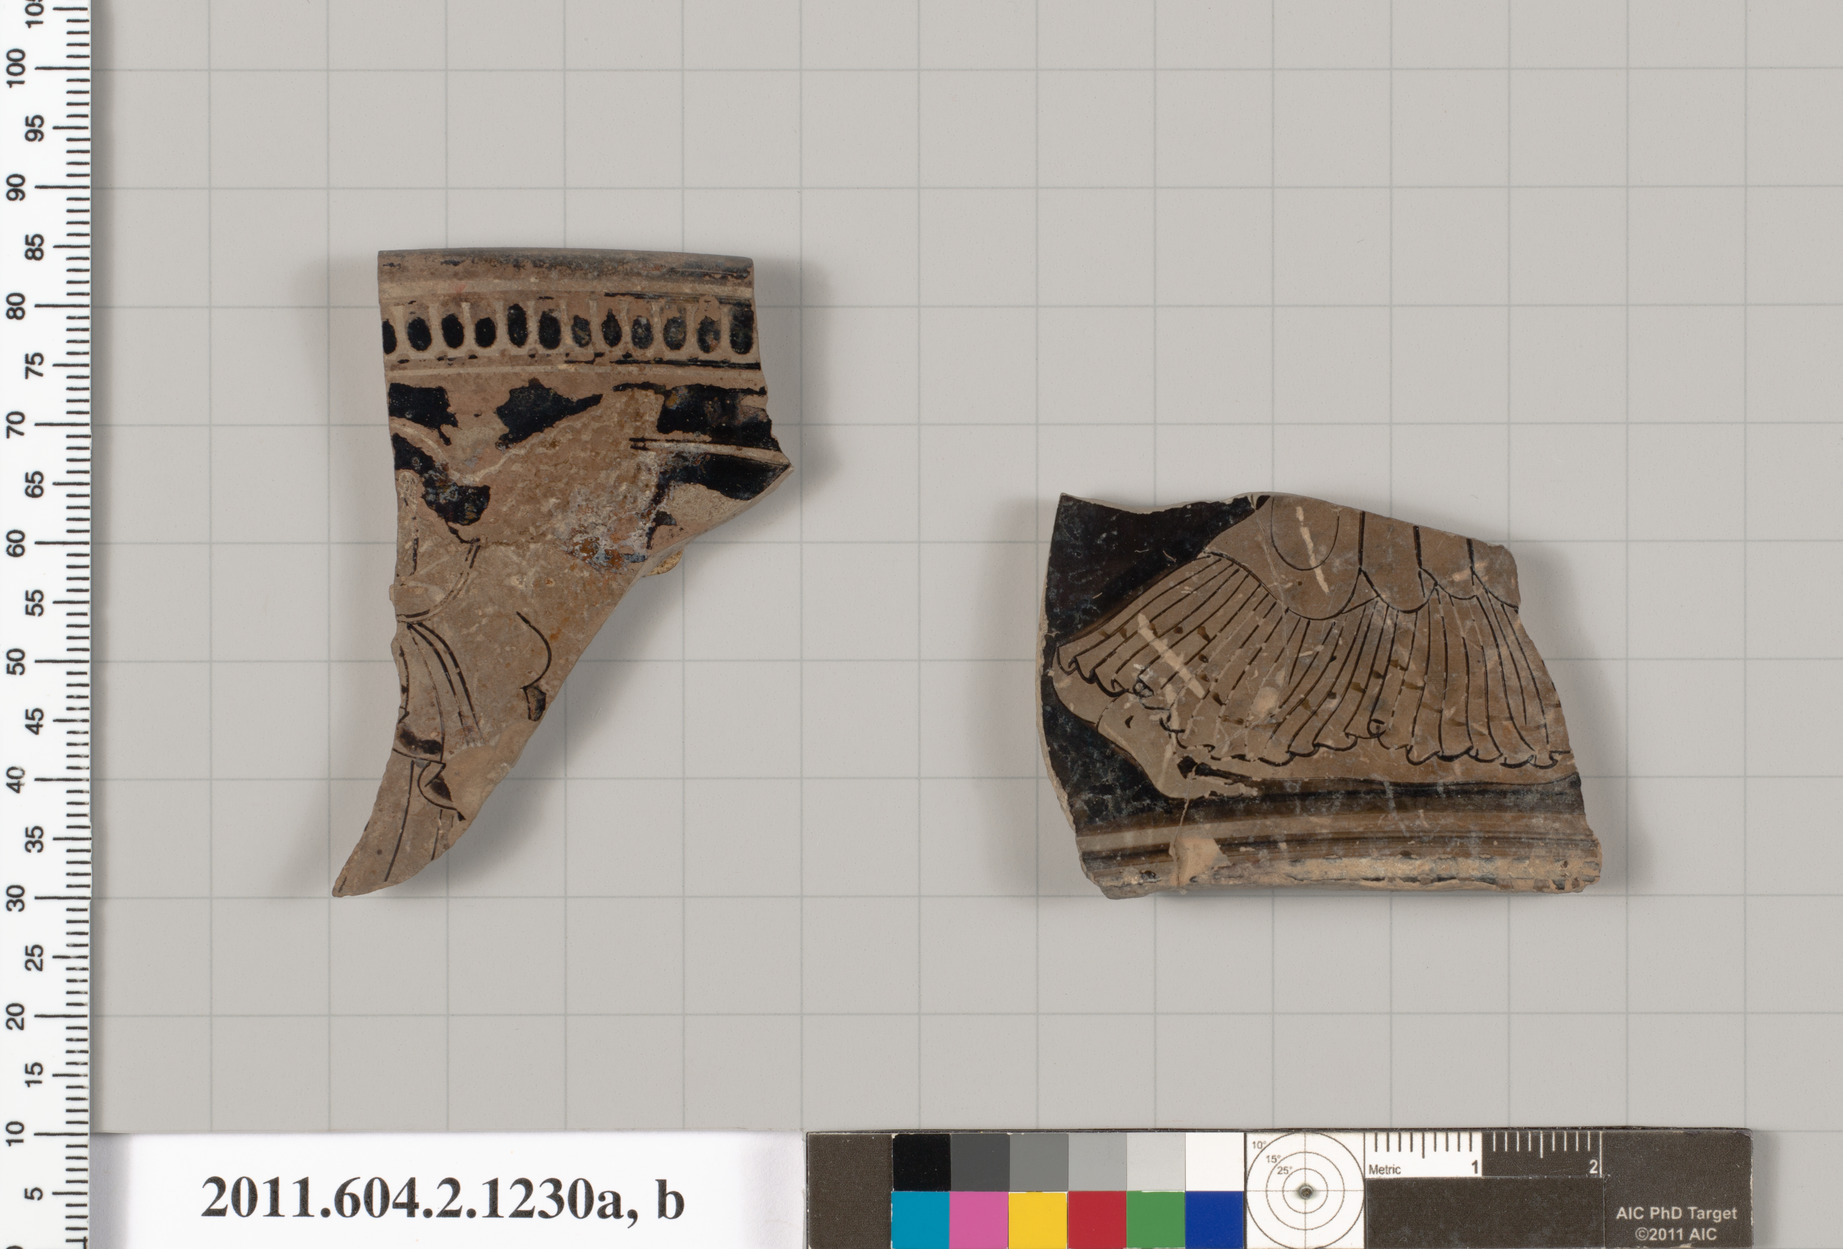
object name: rhyton fragment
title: Terracotta rhyton (vase for libations or drinking)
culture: greek, attic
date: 500-480 BCE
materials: terracotta